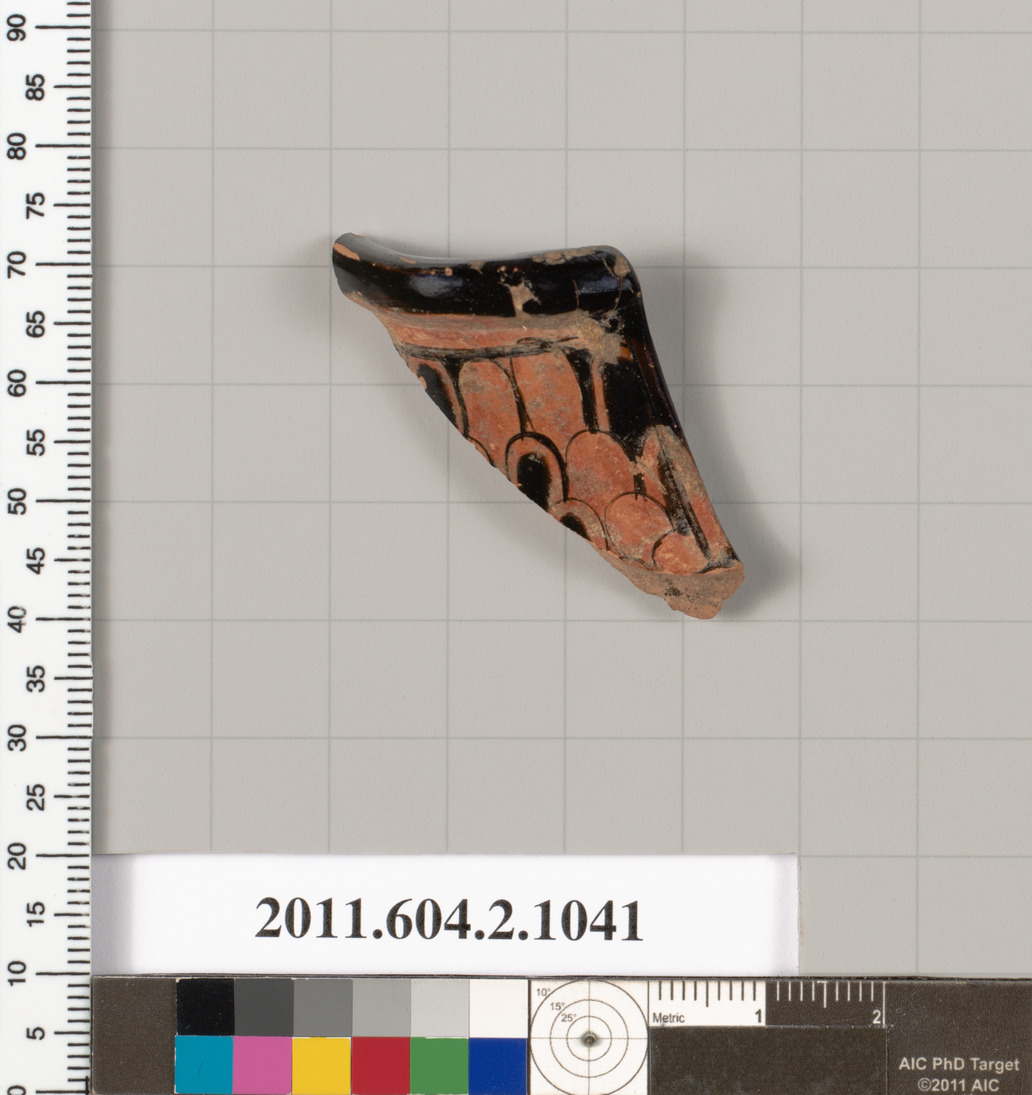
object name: oinochoe fragment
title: Terracotta fragment of an oinochoe (jug)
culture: greek, attic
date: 467-435 BCE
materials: terracotta